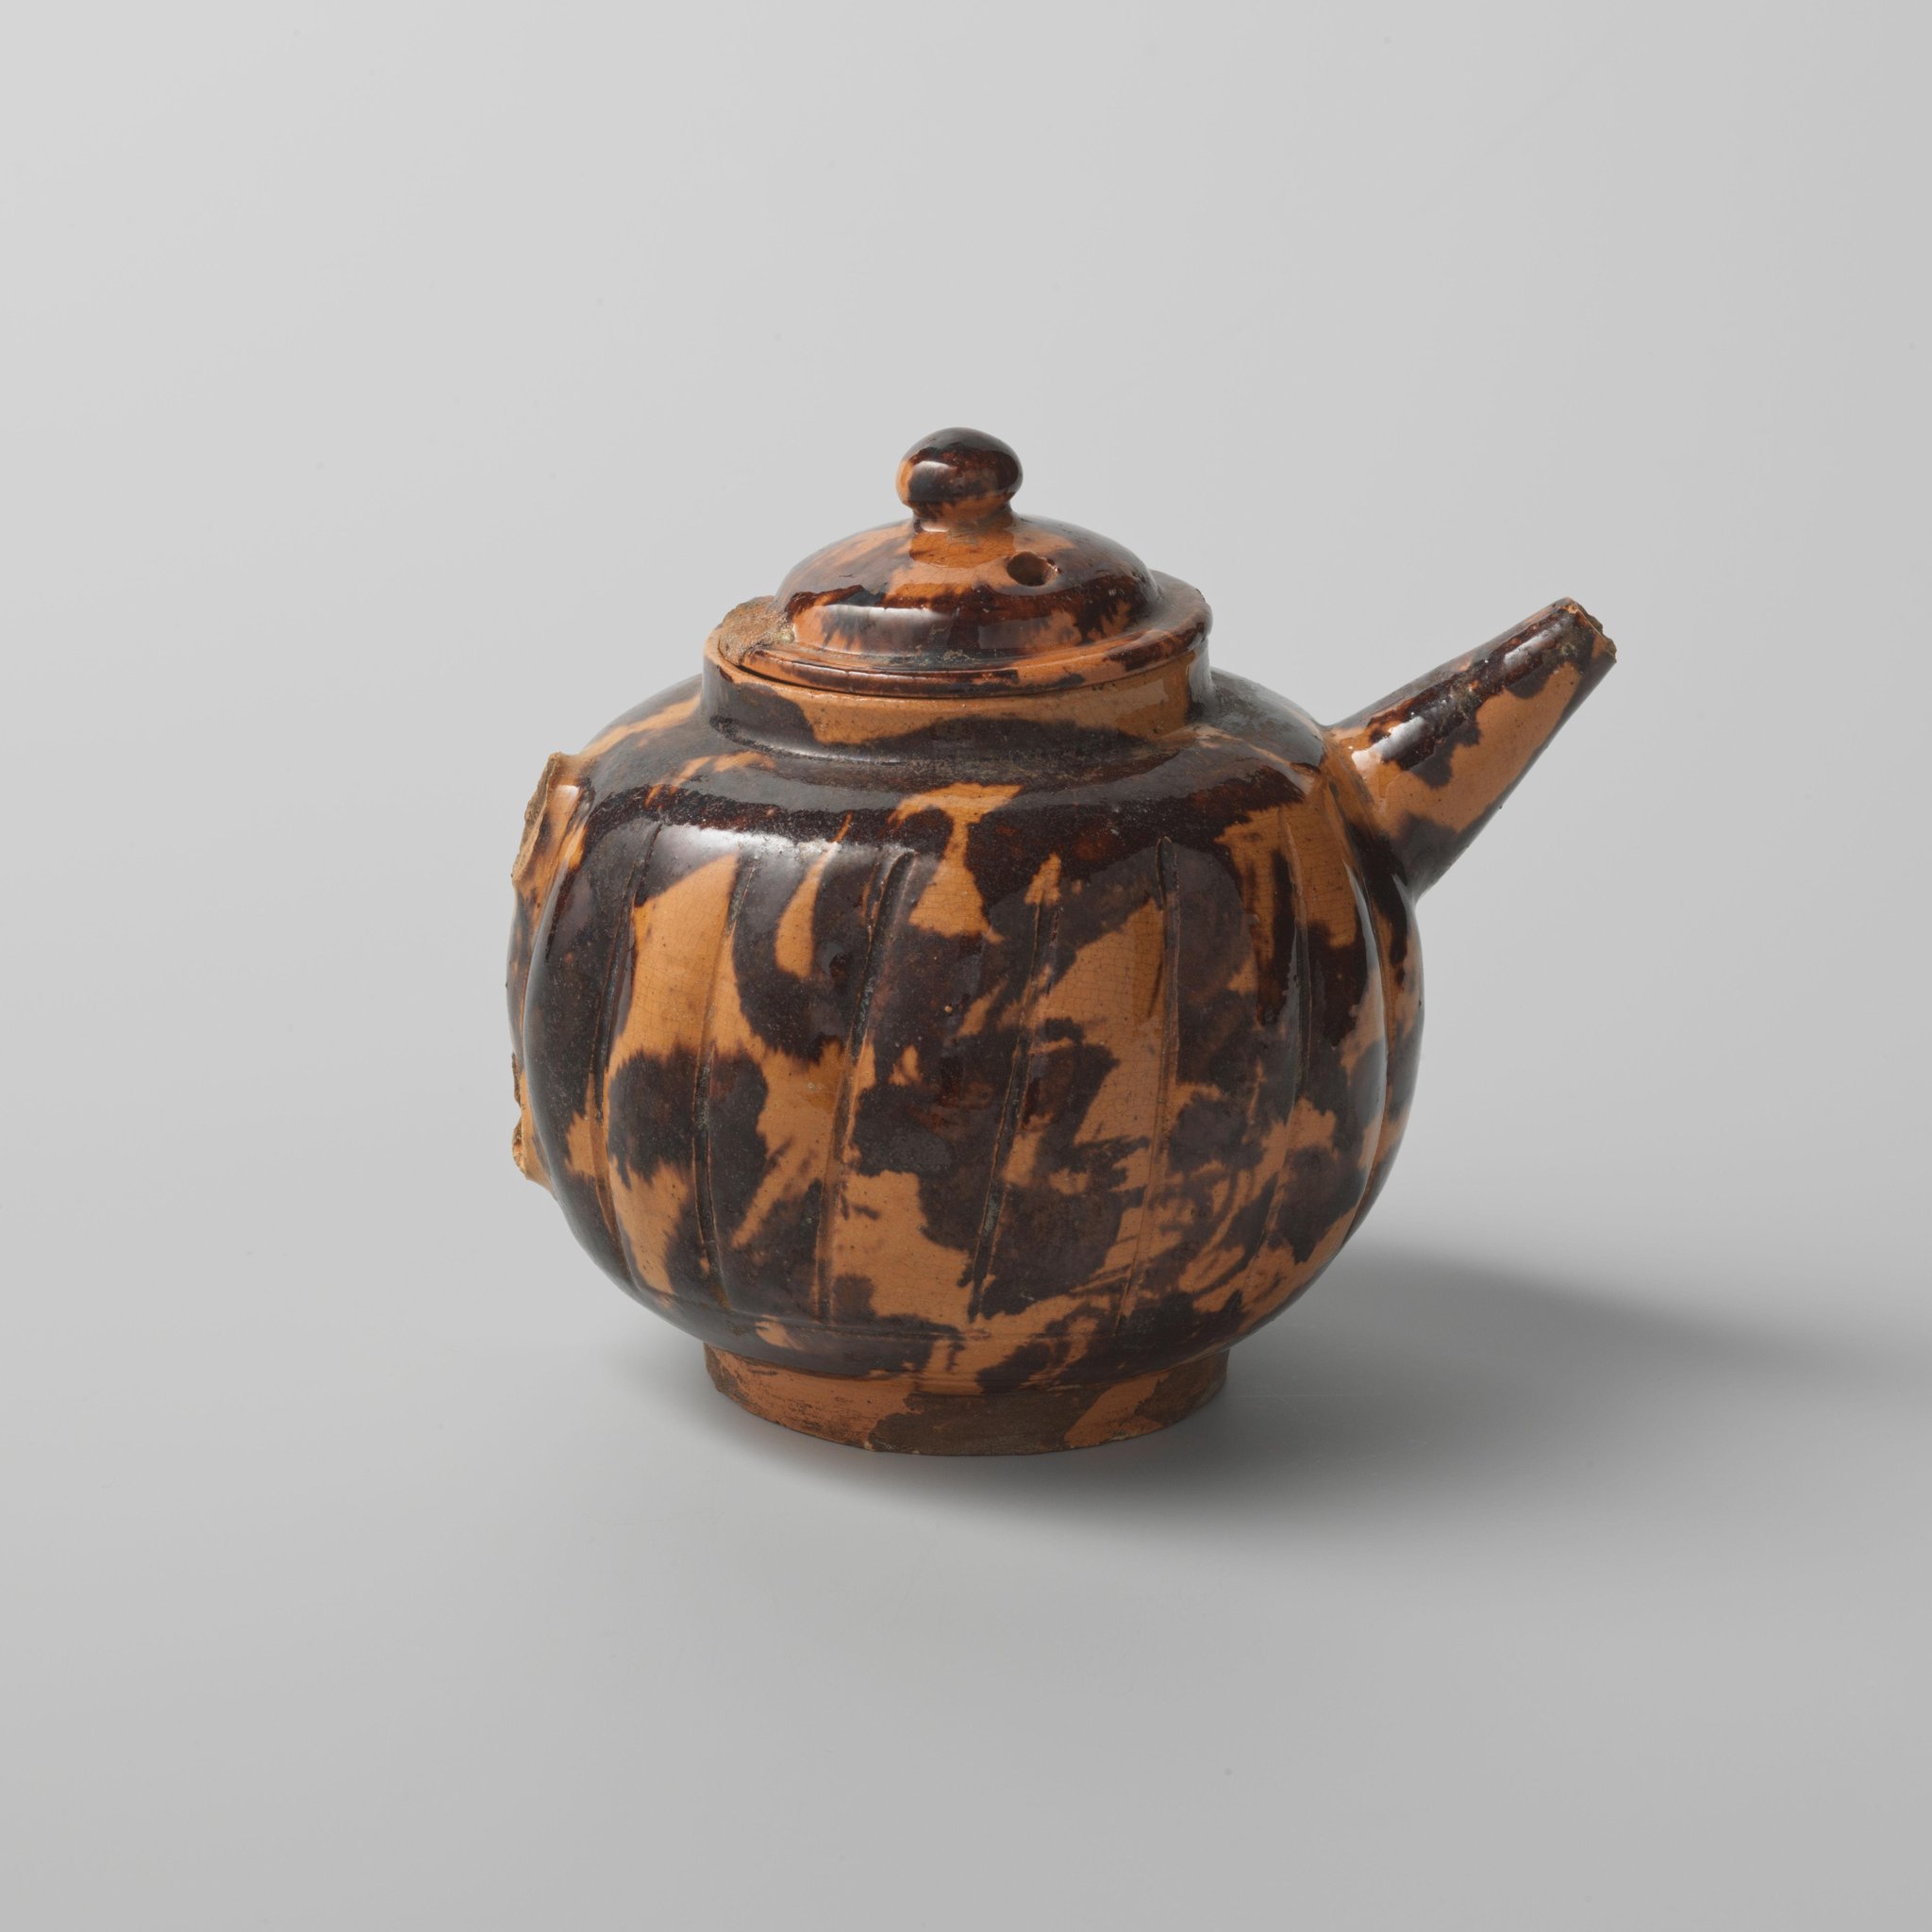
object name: bakafval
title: Theepot met een bruine vlekken (De Caluwe bakafval)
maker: jacobus de caluwe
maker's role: plateelbakkerij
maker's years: -1730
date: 1700-1725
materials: earthenware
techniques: firing, vitrification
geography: delft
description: Toegeschreven aan Jacobus de Caluwe, omdat dit voorwerp samen met gemerkte stukken (‘Jacobus De Caluwe’ en rennend hert) gevonden is op de plaats waar zich De Caluwes tweede werkplaats bevond. Er is een duidelijke stilistische overeenkomst tussen de gemerkte en niet gemerkte voorwerpen uit deze archeologische vondst.